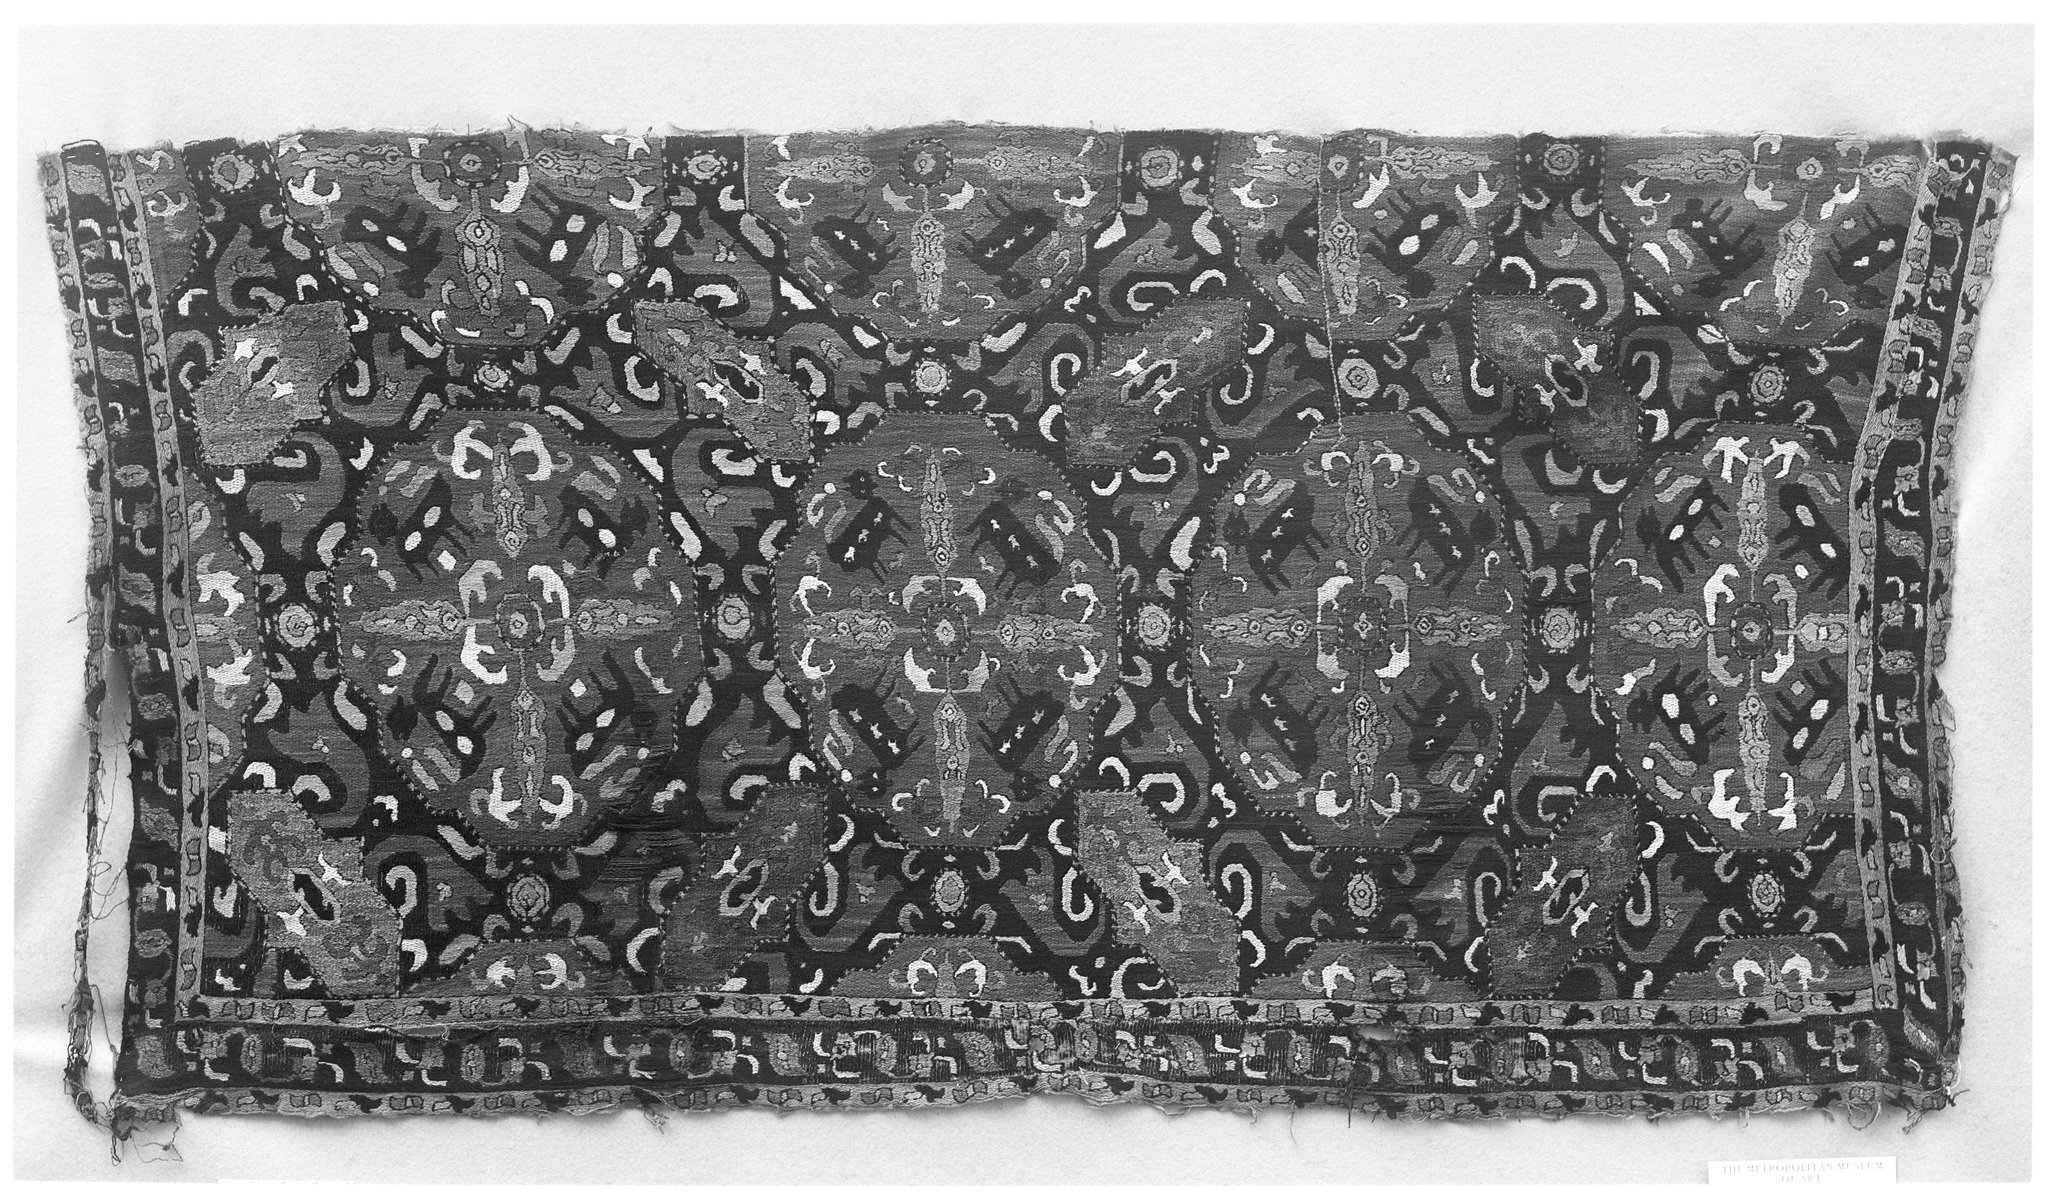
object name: textile fragment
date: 1601-1700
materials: silk, wool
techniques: embroidery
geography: iran